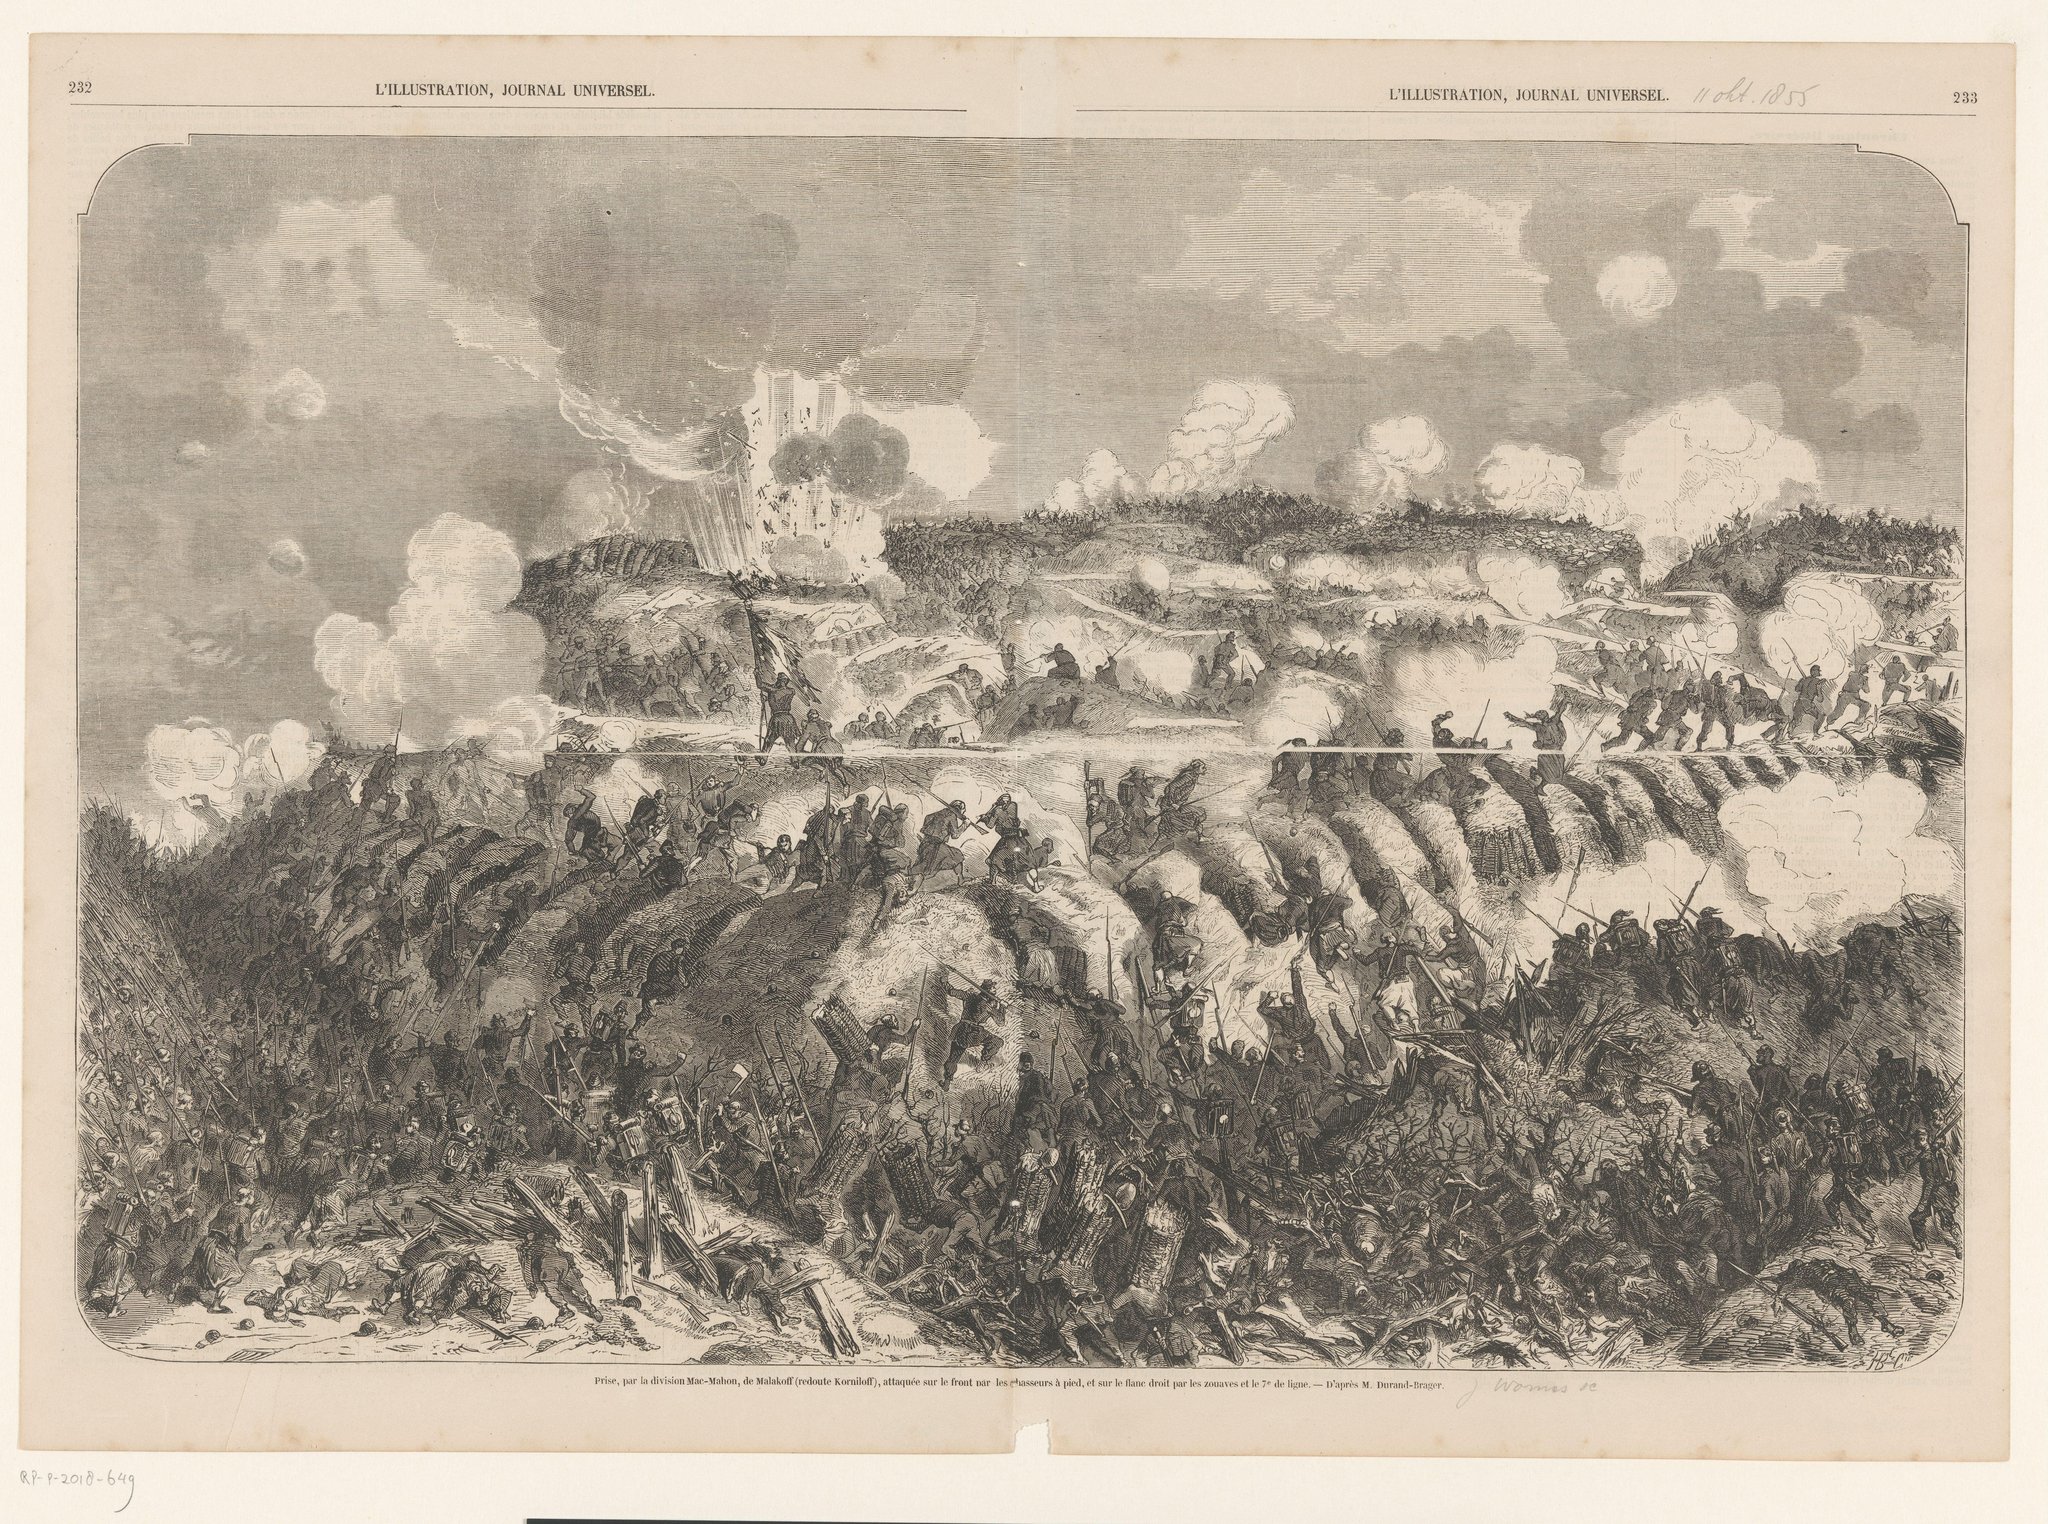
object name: print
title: Slag bij Malachov, 1855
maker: jules worms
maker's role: painter, print maker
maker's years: 1832-1924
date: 1855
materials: paper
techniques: engraving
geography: france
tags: battle (+ land forces)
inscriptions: collector's mark: Lugt 2228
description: Slag bij Malachov op 7 september 1855 waarbij de geallieerden de redoute van Malachov veroverden. Onderdeel van het beleg van Sebastopol tijdens de Krimoorlog.